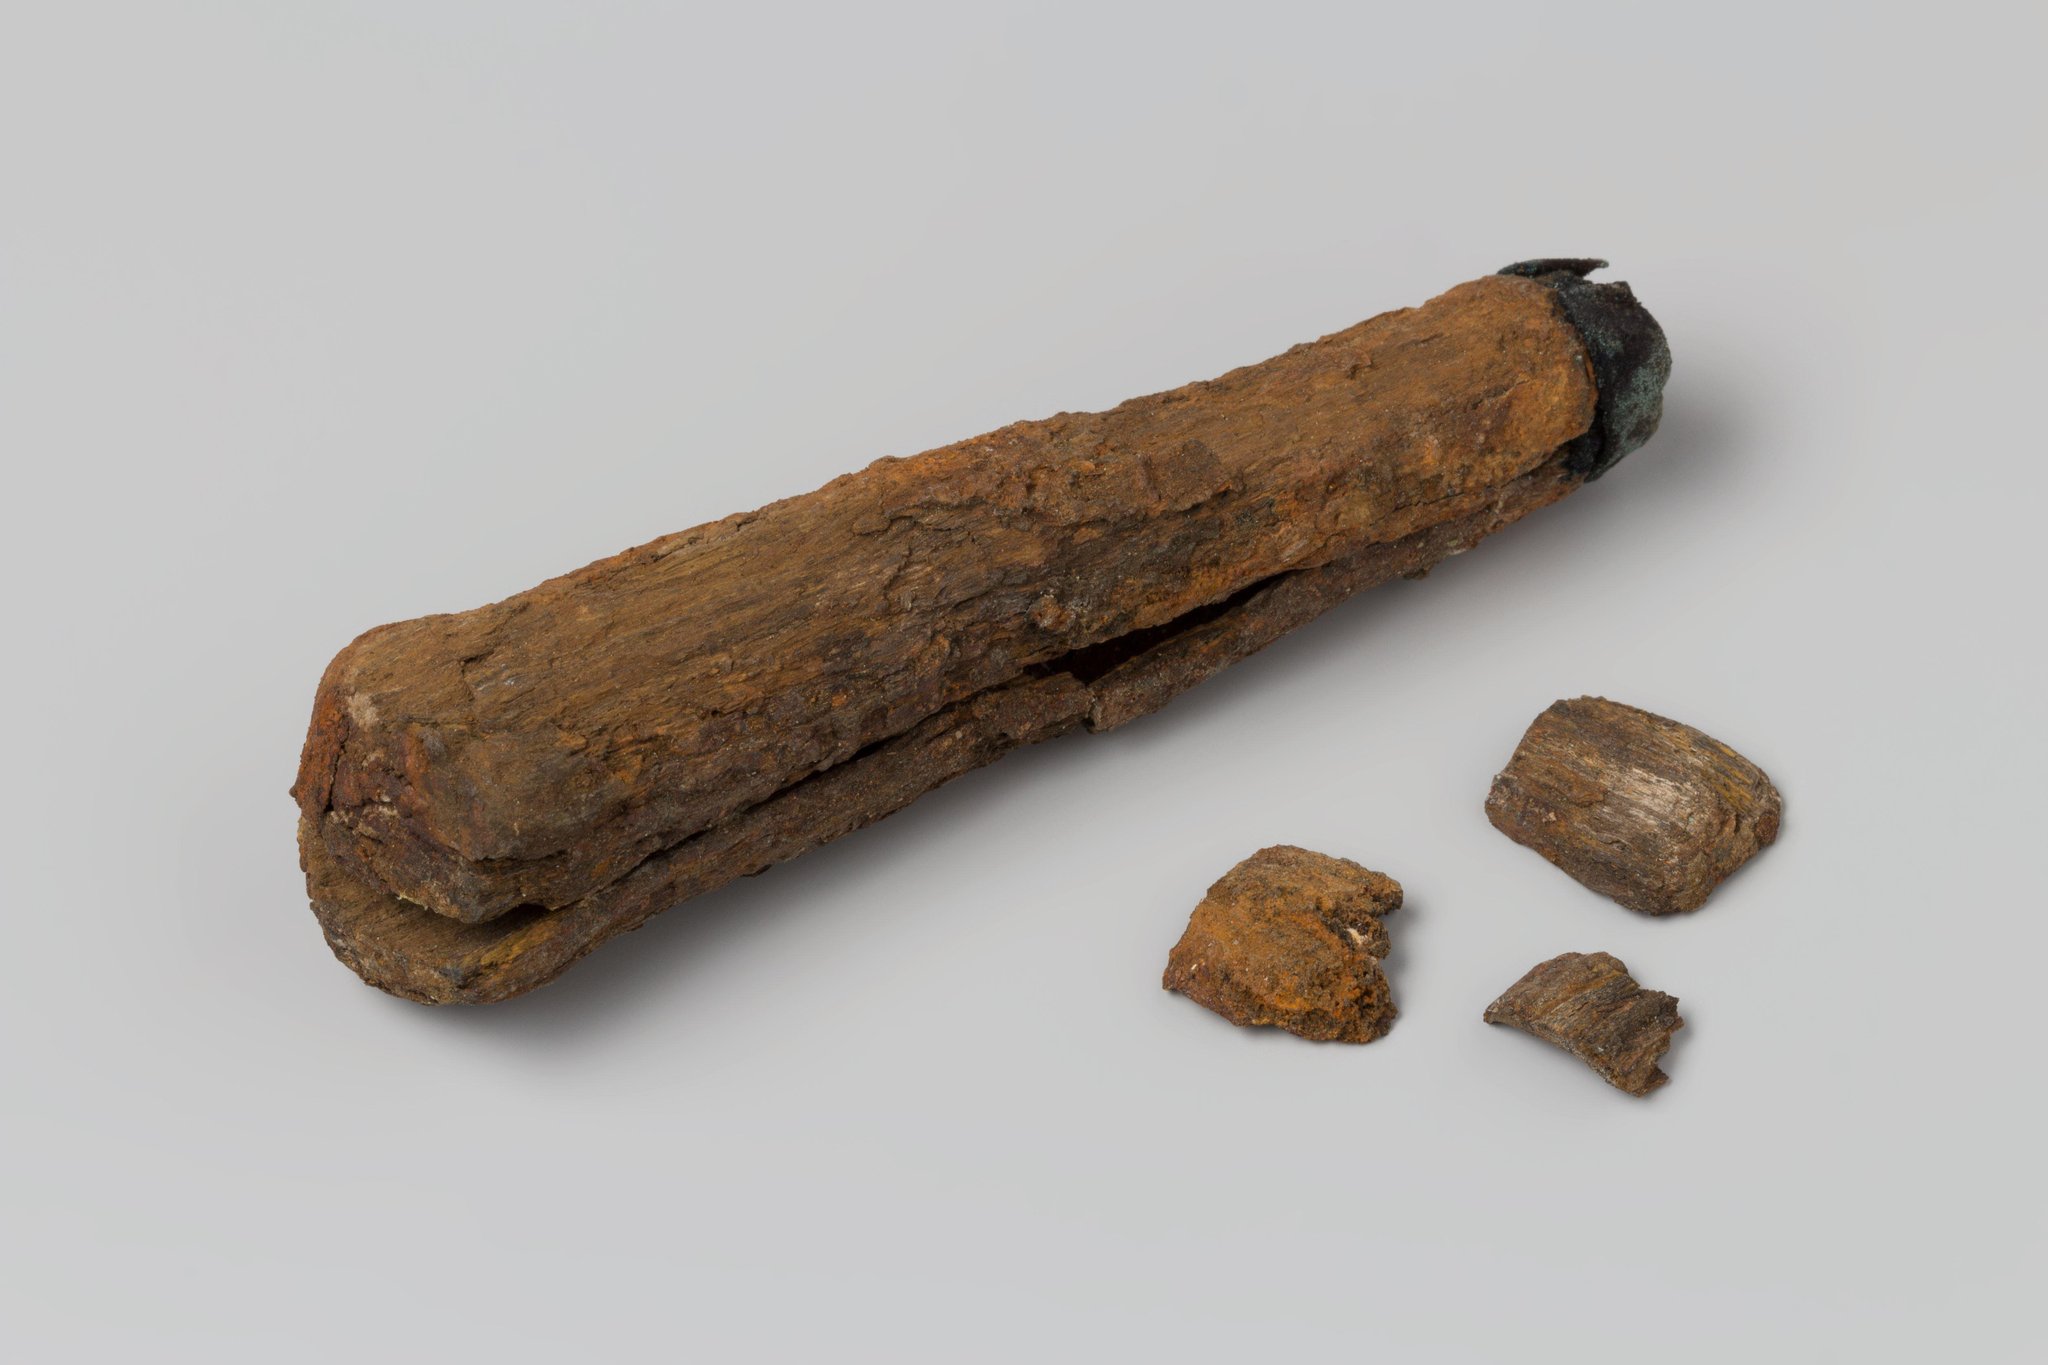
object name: knife handle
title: Messenheft uit het wrak van de Oost-Indiëvaarder Hollandia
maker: Anonymous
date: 1700-1743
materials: copper, wood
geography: netherlands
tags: verenigde oostindische compagnie, hollandia (schip), annet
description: Knife, handle, cylindrical: tapering; id. NG 1979-403H, eroded.